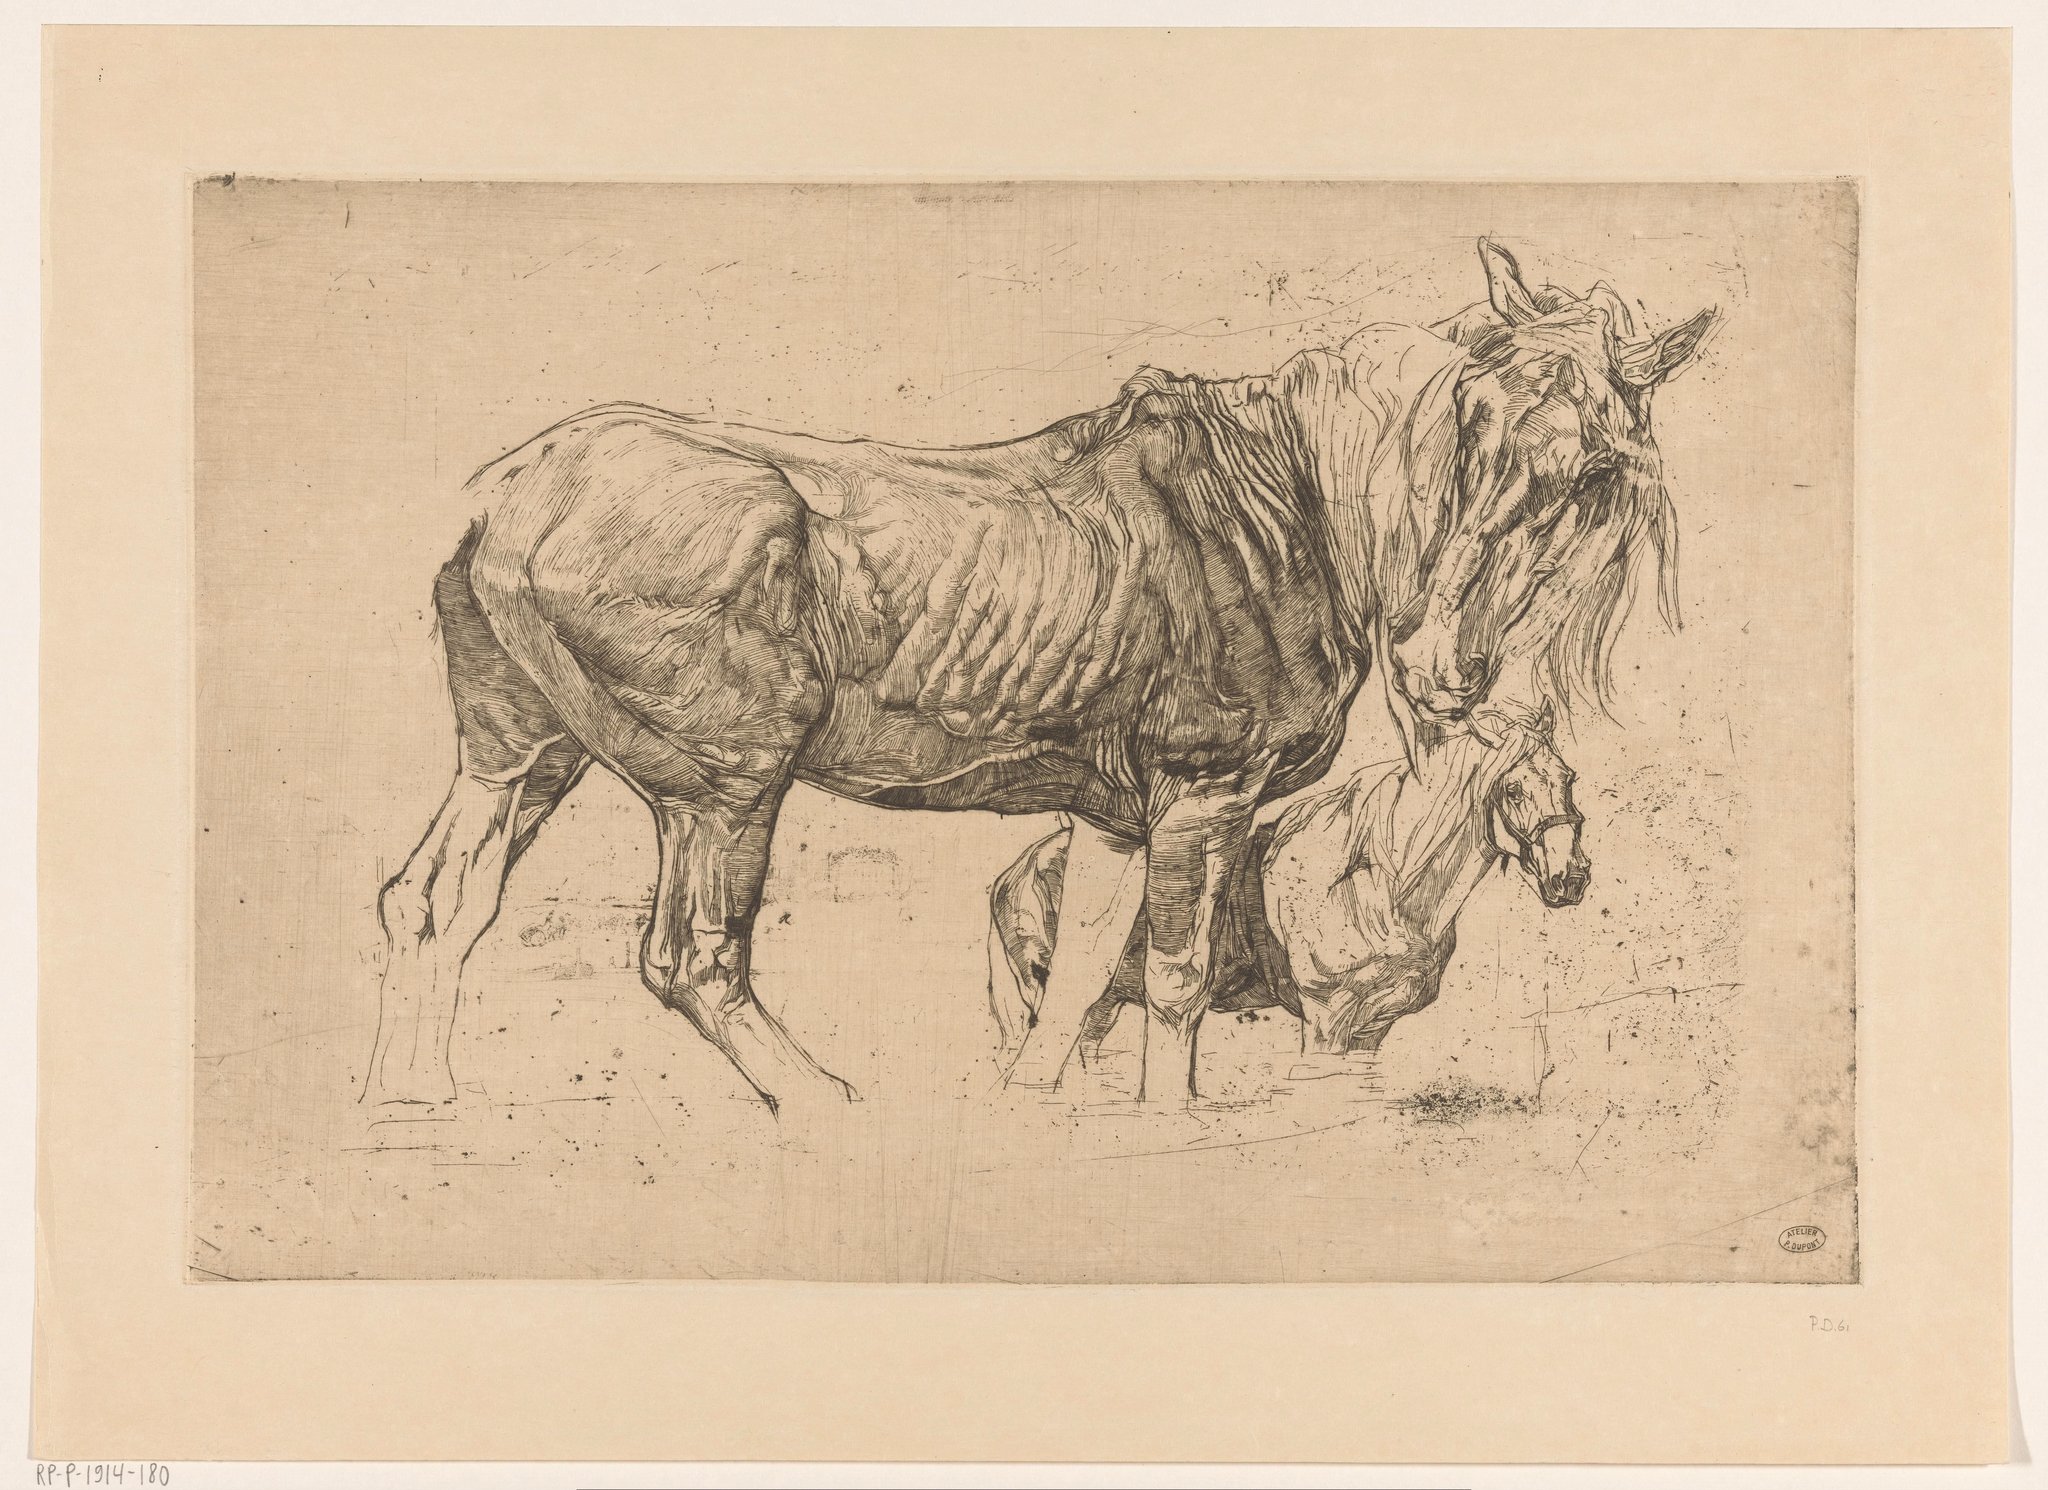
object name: print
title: Twee paarden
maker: pieter dupont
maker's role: draughtsman, print maker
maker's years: 1870-1911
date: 1897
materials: paper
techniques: intaglio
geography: paris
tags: horse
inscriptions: collector's mark: Lugt 2233, workshop stamp: ‘ATELIER P. DUPONT’